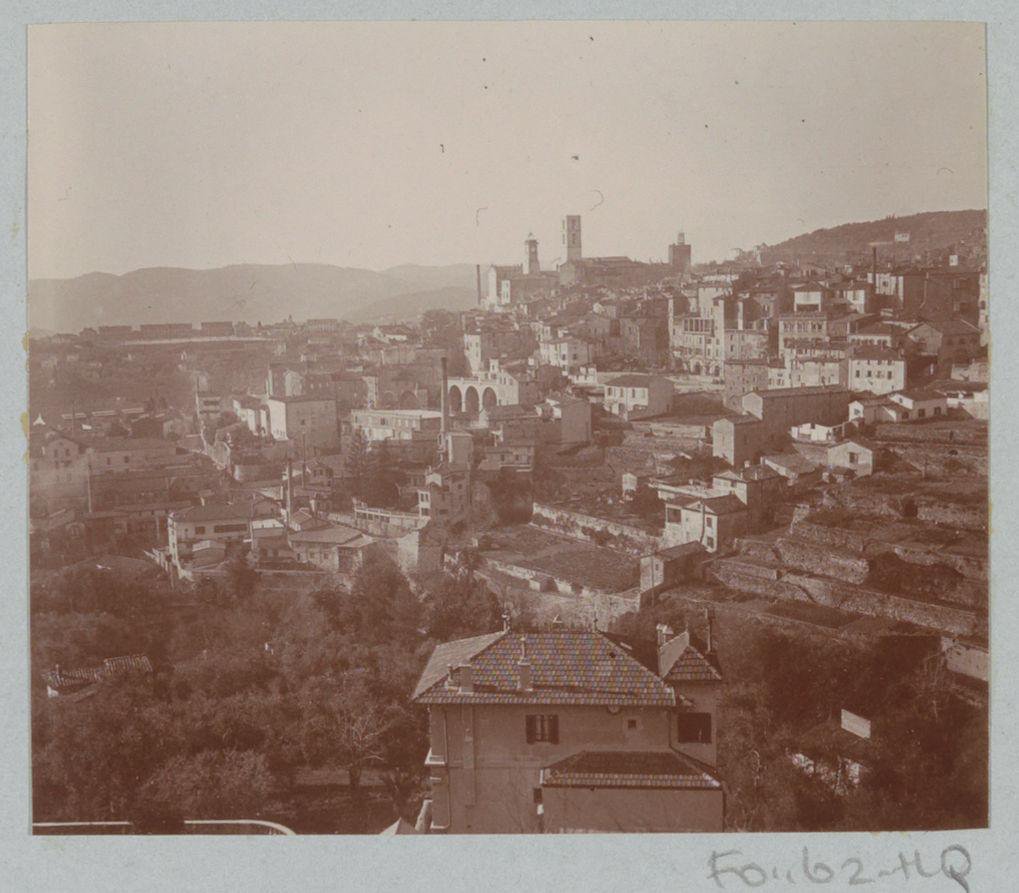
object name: photograph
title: Gezicht op een stad in de bergen, vermoedelijk in Zuid-Frankrijk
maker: Anonymous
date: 1905-1910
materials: paper, photographic support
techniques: gelatin silver print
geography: southern france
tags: prospect of city, town panorama, silhouette of city, mountains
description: Onderdeel van Fotoalbum van een Franse amateurfotograaf met bezienswaardigheden in Frankrijk, Zwitserland en Italië.